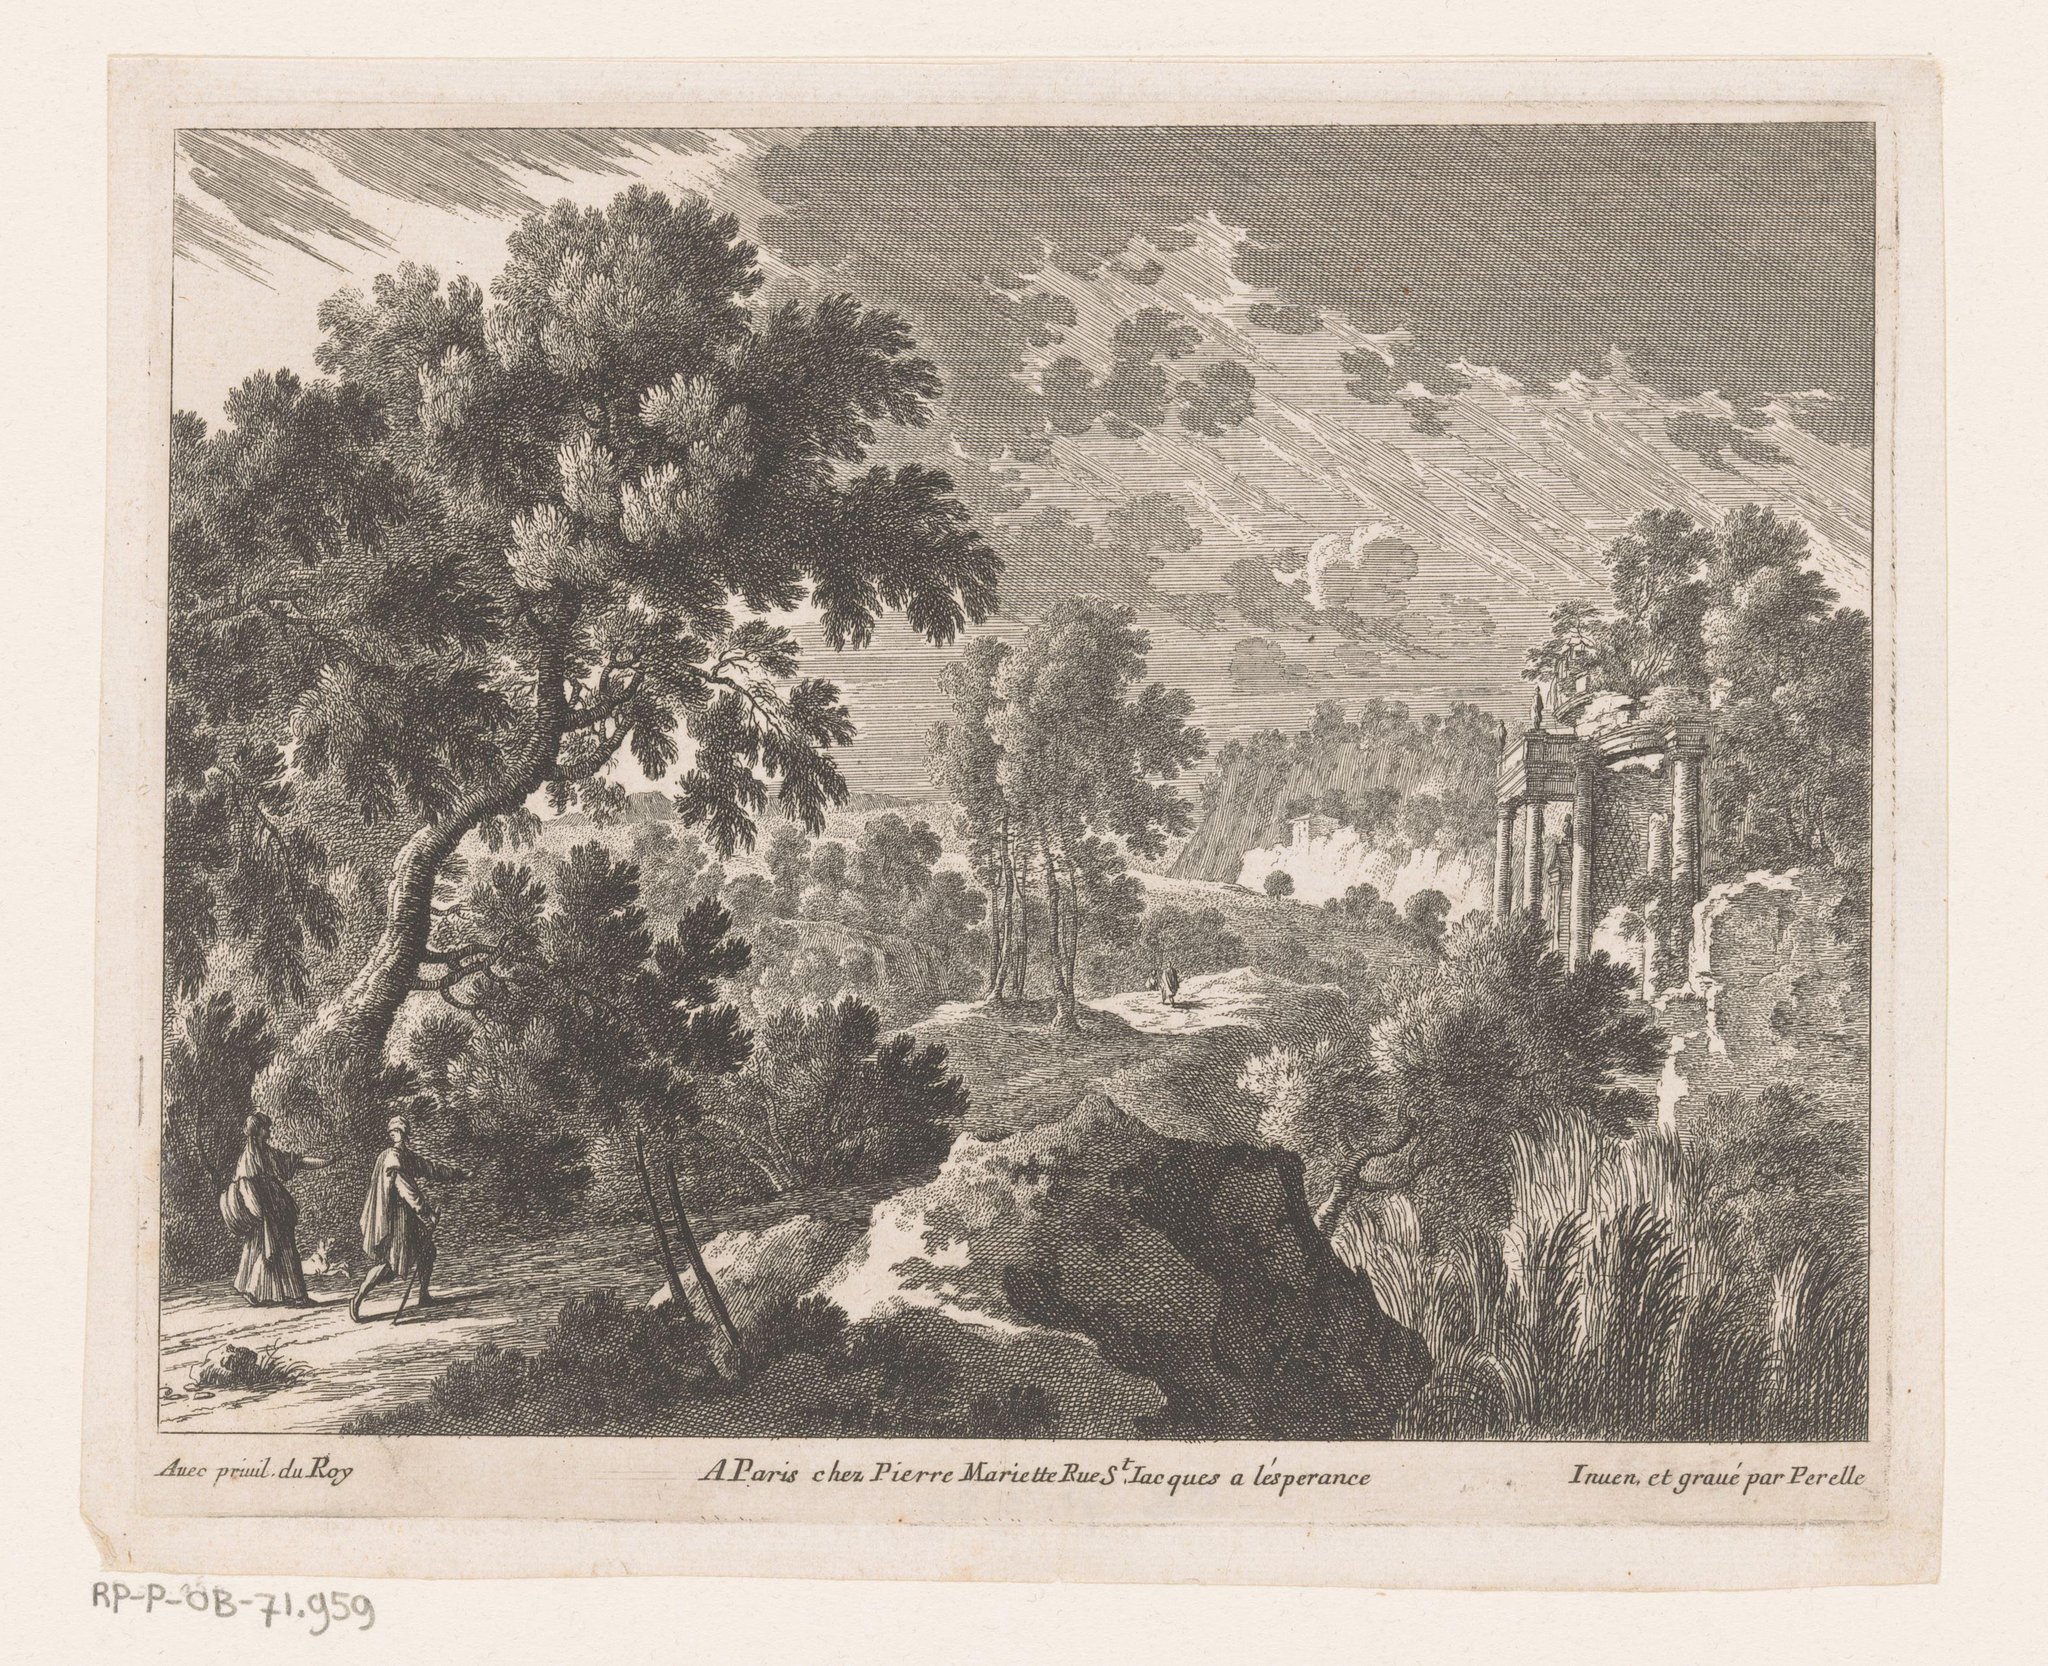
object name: print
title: Landschap met wandelende man en vrouw bij ruïne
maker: lodewijk xiv (koning van frankrijk)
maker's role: koning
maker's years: 1638-1715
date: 1613-1695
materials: paper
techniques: engraving, etching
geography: france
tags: landscape with ruins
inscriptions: collector's mark: Lugt 240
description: Prenten met het signatuur 'Perelle' kunnen zowel door vader Gabriel als door zonen Nicolas en Adam gemaakt zijn.